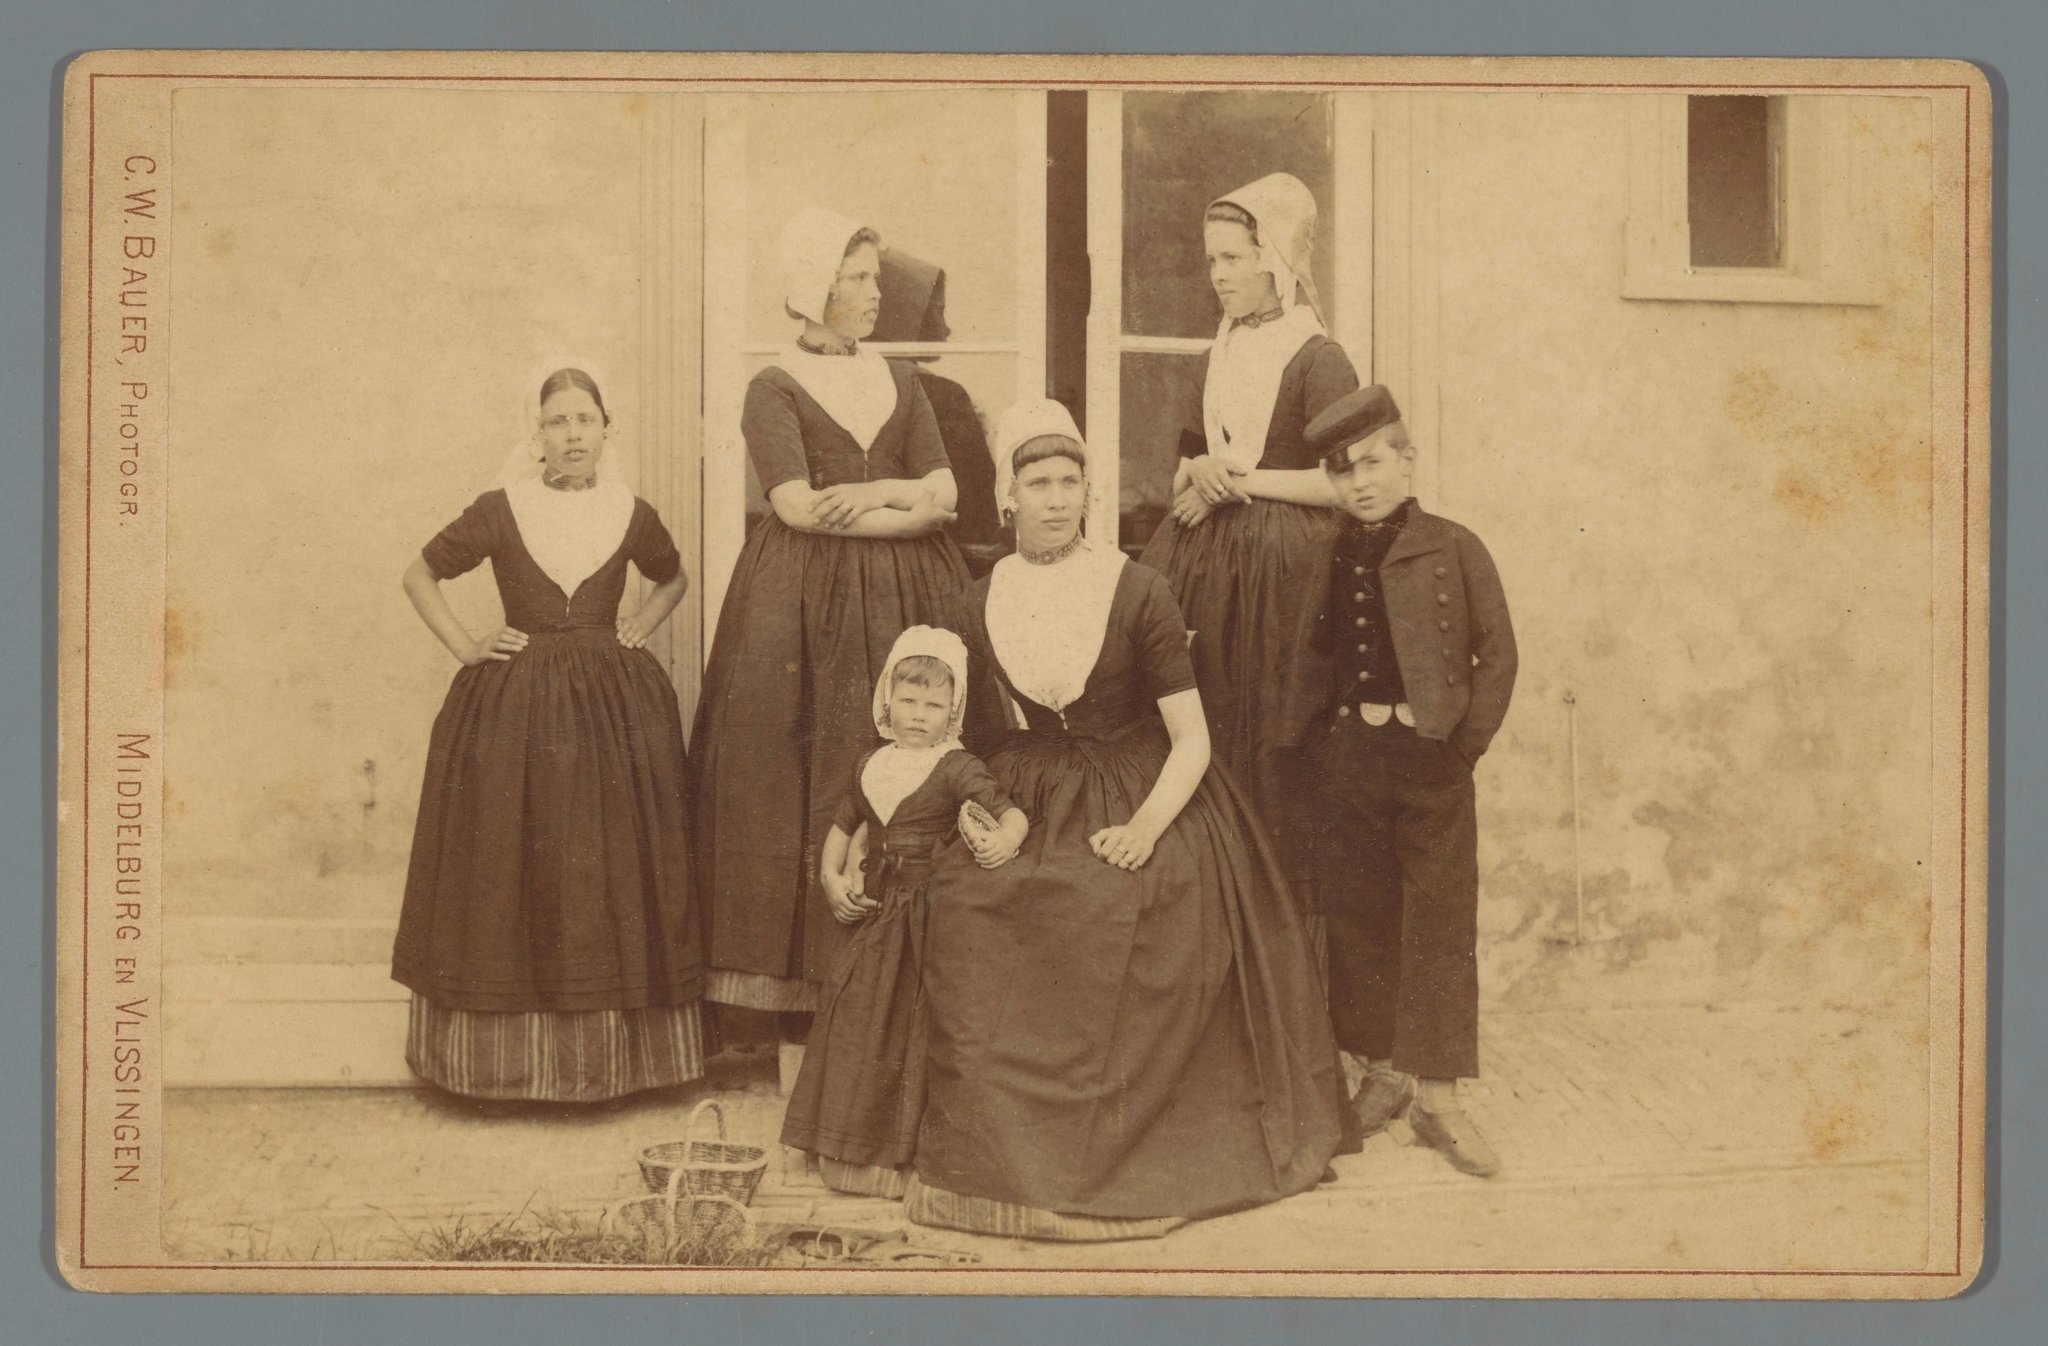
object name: photograph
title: Groepsportret van kinderen in klederdracht van Walcheren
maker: carl wilhelm bauer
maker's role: fotograaf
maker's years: 1844-1911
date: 1875-1900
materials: cardboard, photographic support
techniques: albumen print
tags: folk costume, regional costume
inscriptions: : ‘Middelburg en Vlissingen’